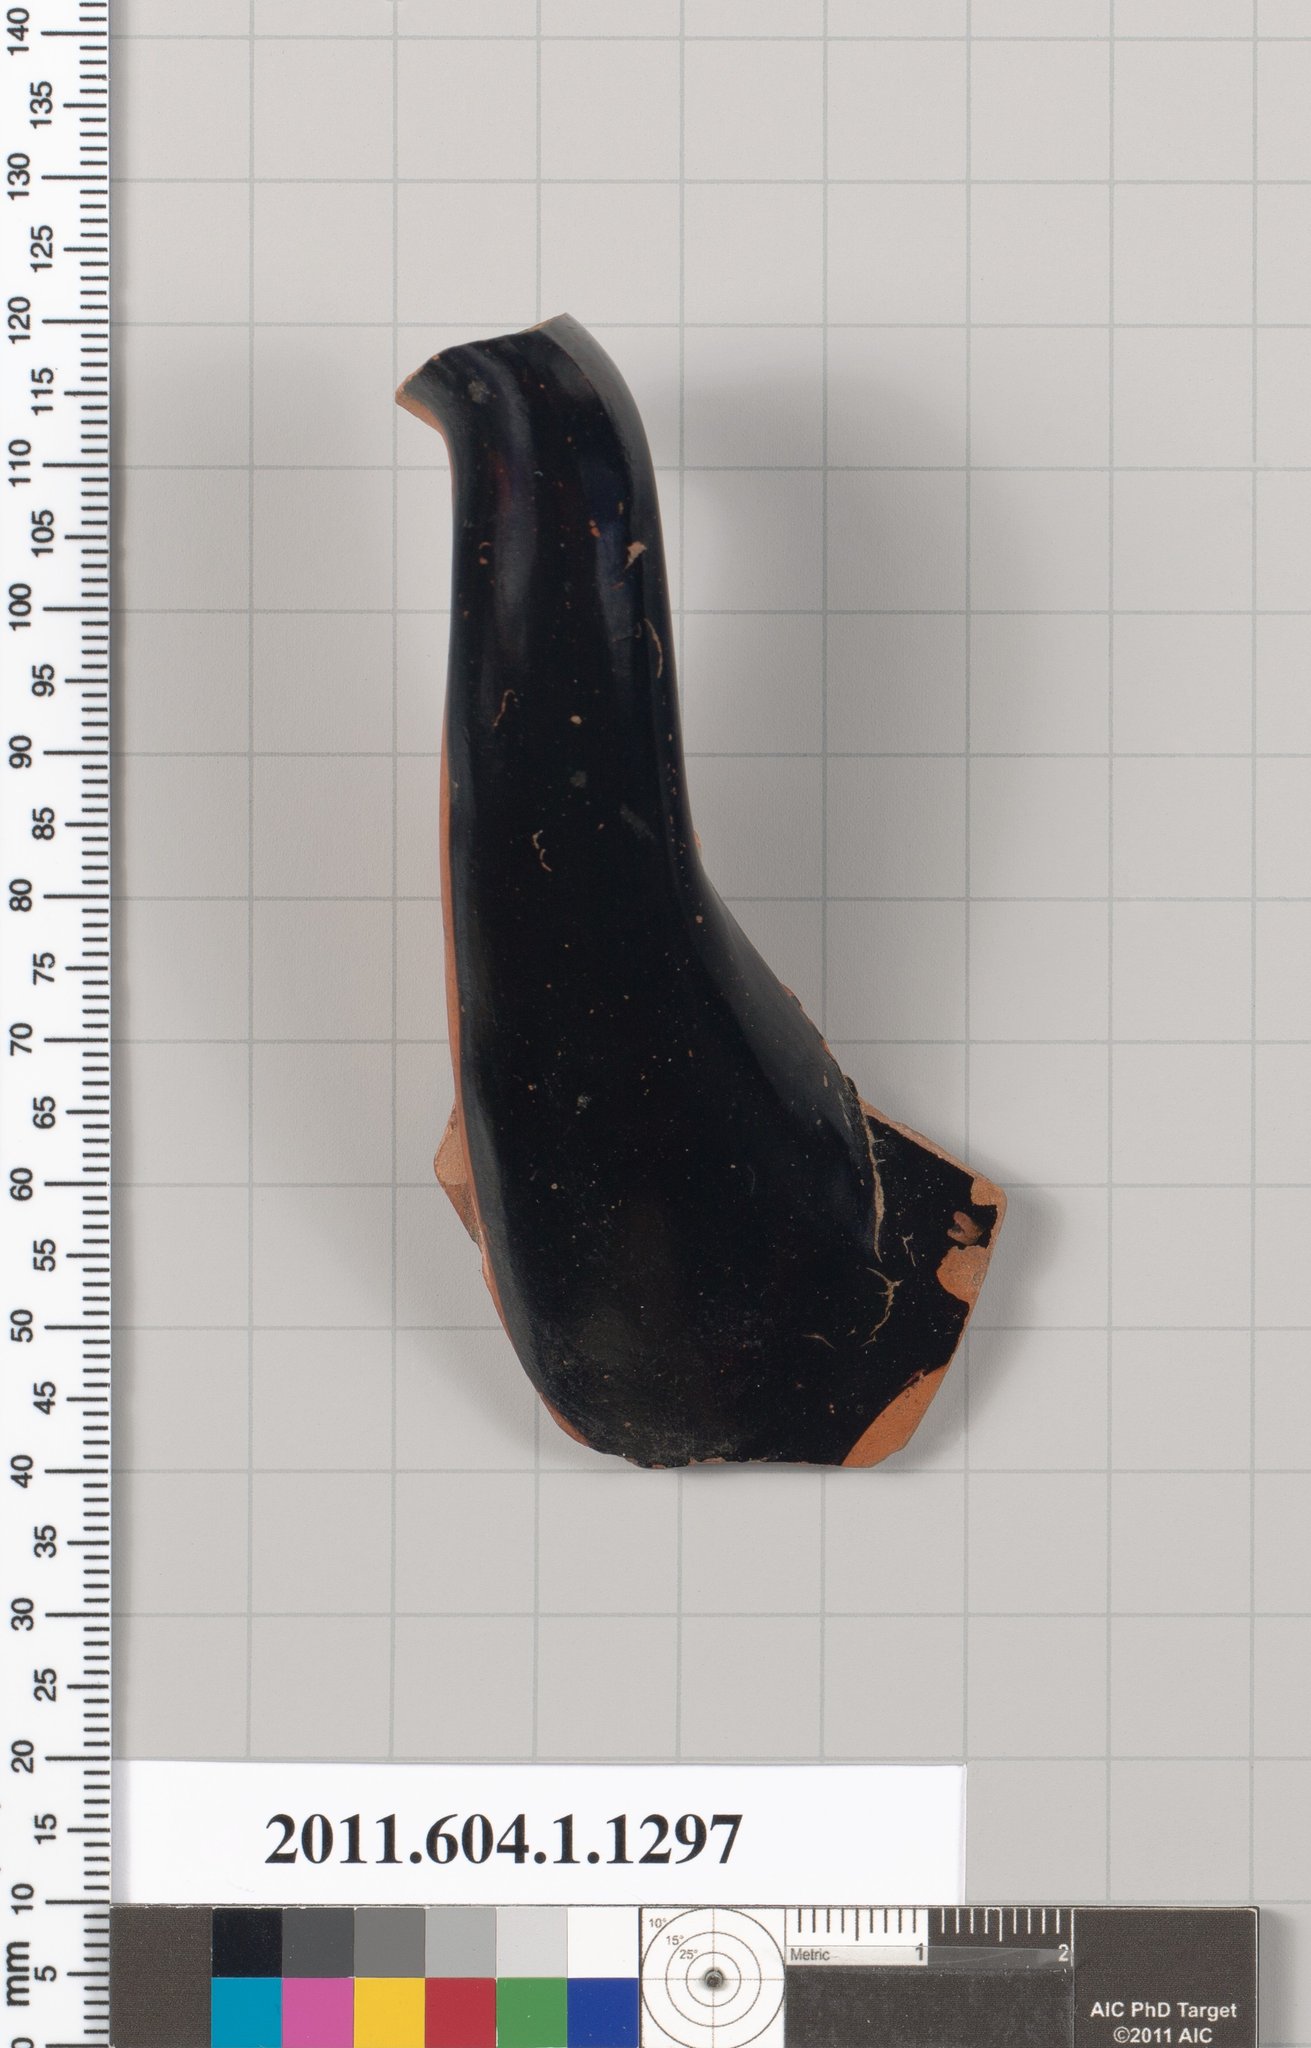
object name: kylix fragment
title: Terracotta fragment of a kylix (drinking cup)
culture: greek, attic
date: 534-468 BCE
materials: terracotta